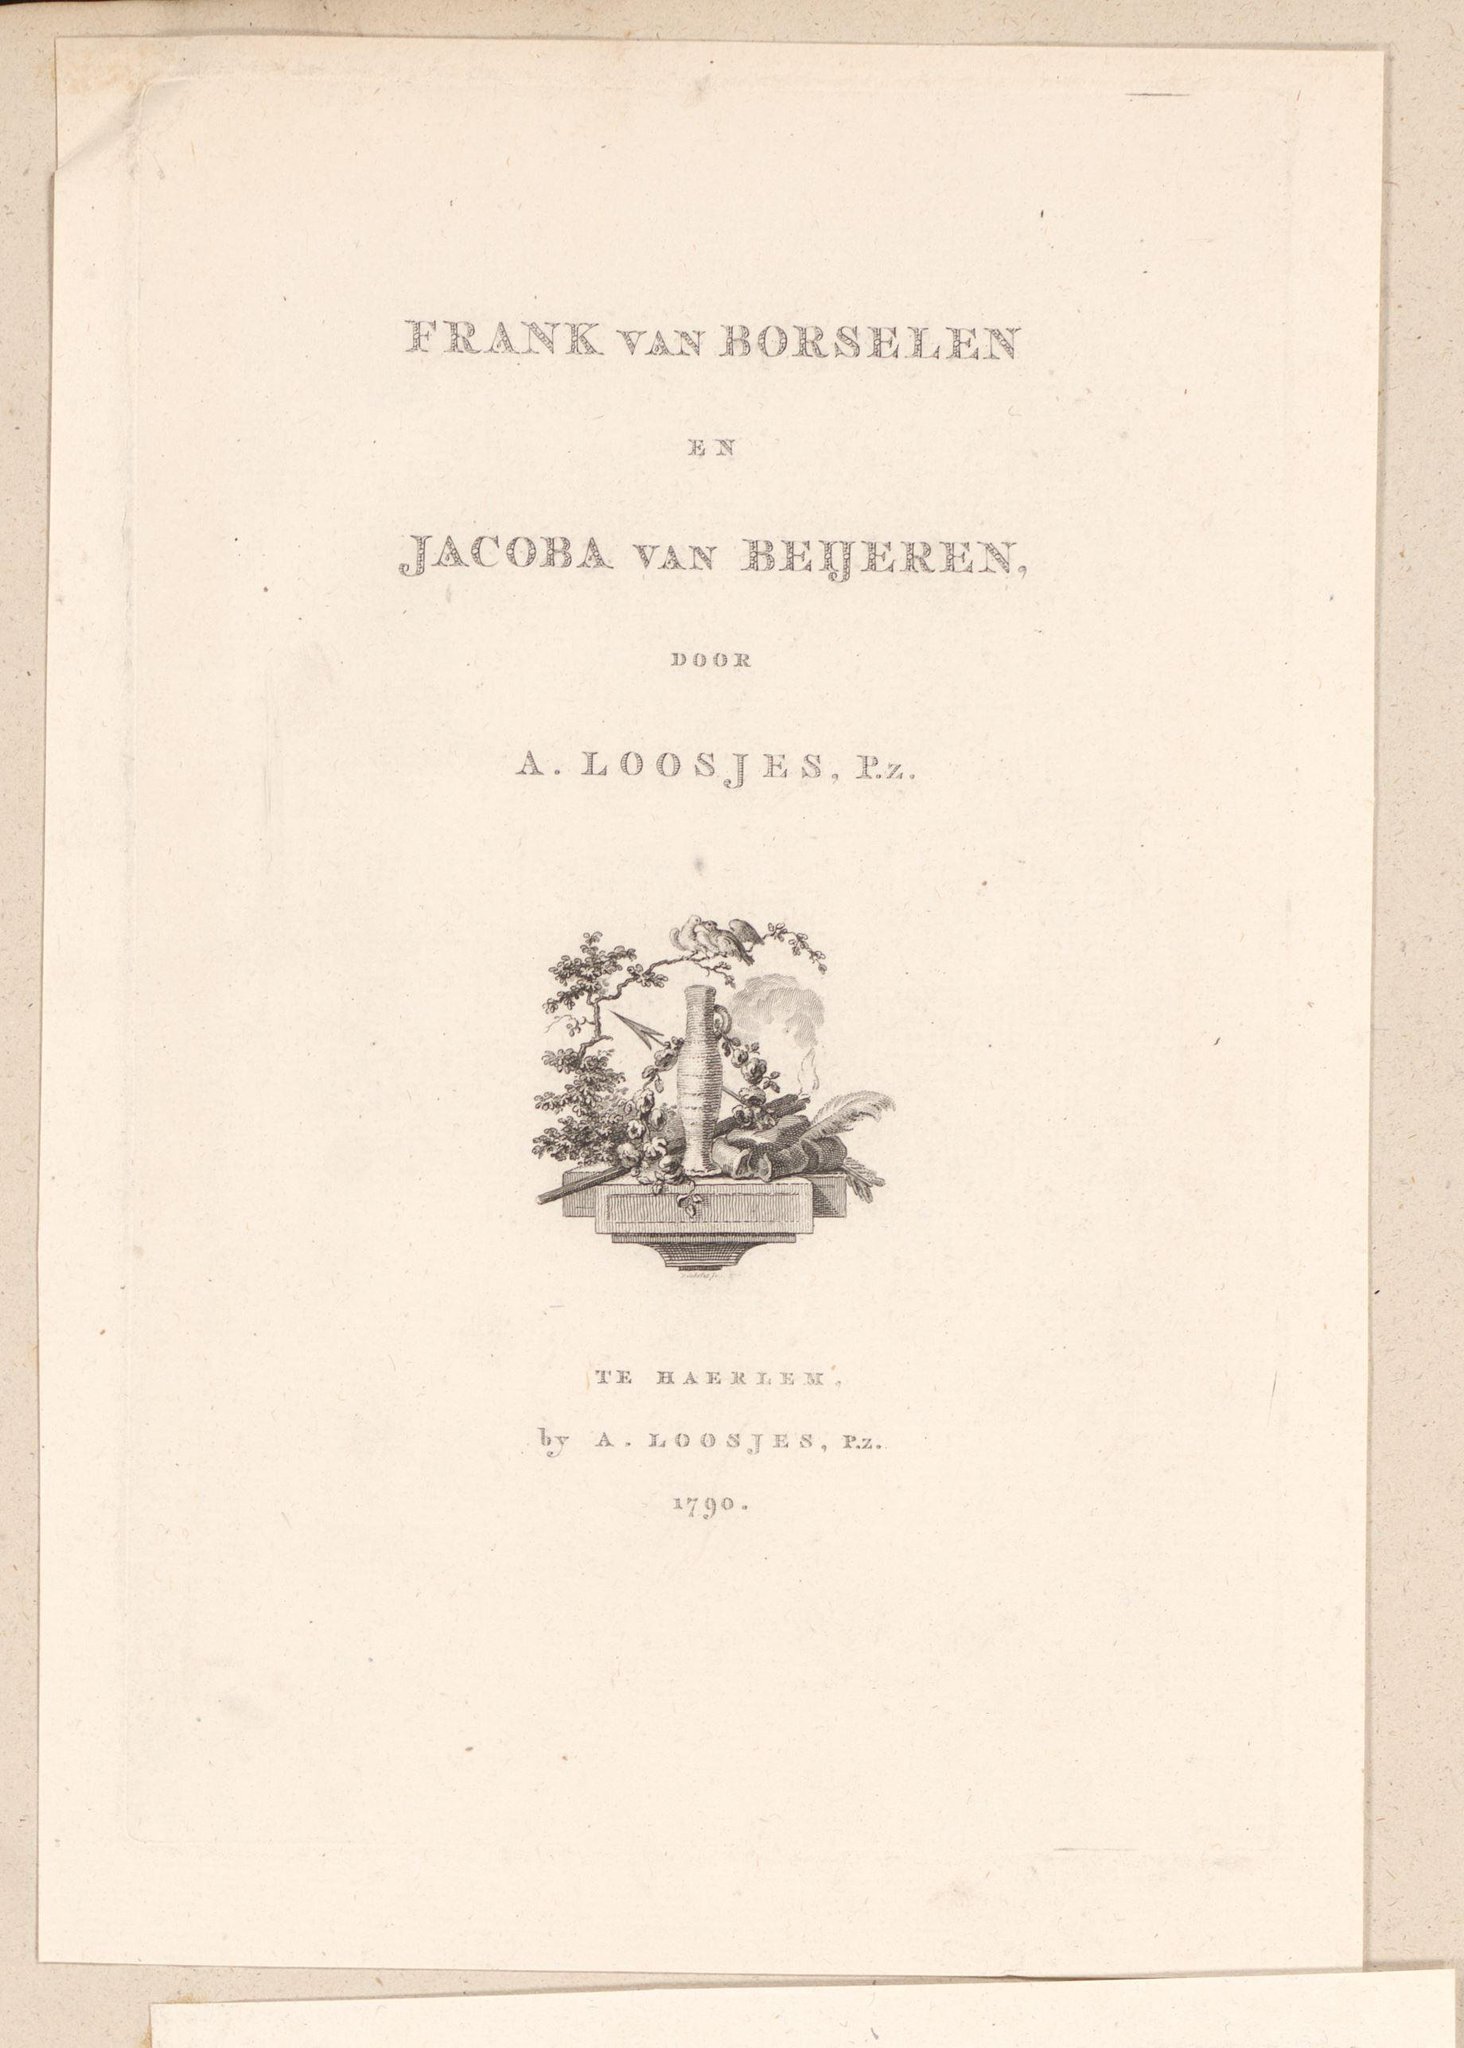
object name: print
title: Titelpagina voor: Adriaan Pietersz. Loosjes, Frank van Borselen en Jacoba van Beijeren, 1790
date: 1790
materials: paper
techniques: etching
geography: amsterdam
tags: title-page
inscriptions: date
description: Gebruikt als titelpagina voor: Loosjes Pietersz., Adriaan. Frank van Borselen en Jacoba van Beijeren. Haarlem: A. Loosjes, 1790.